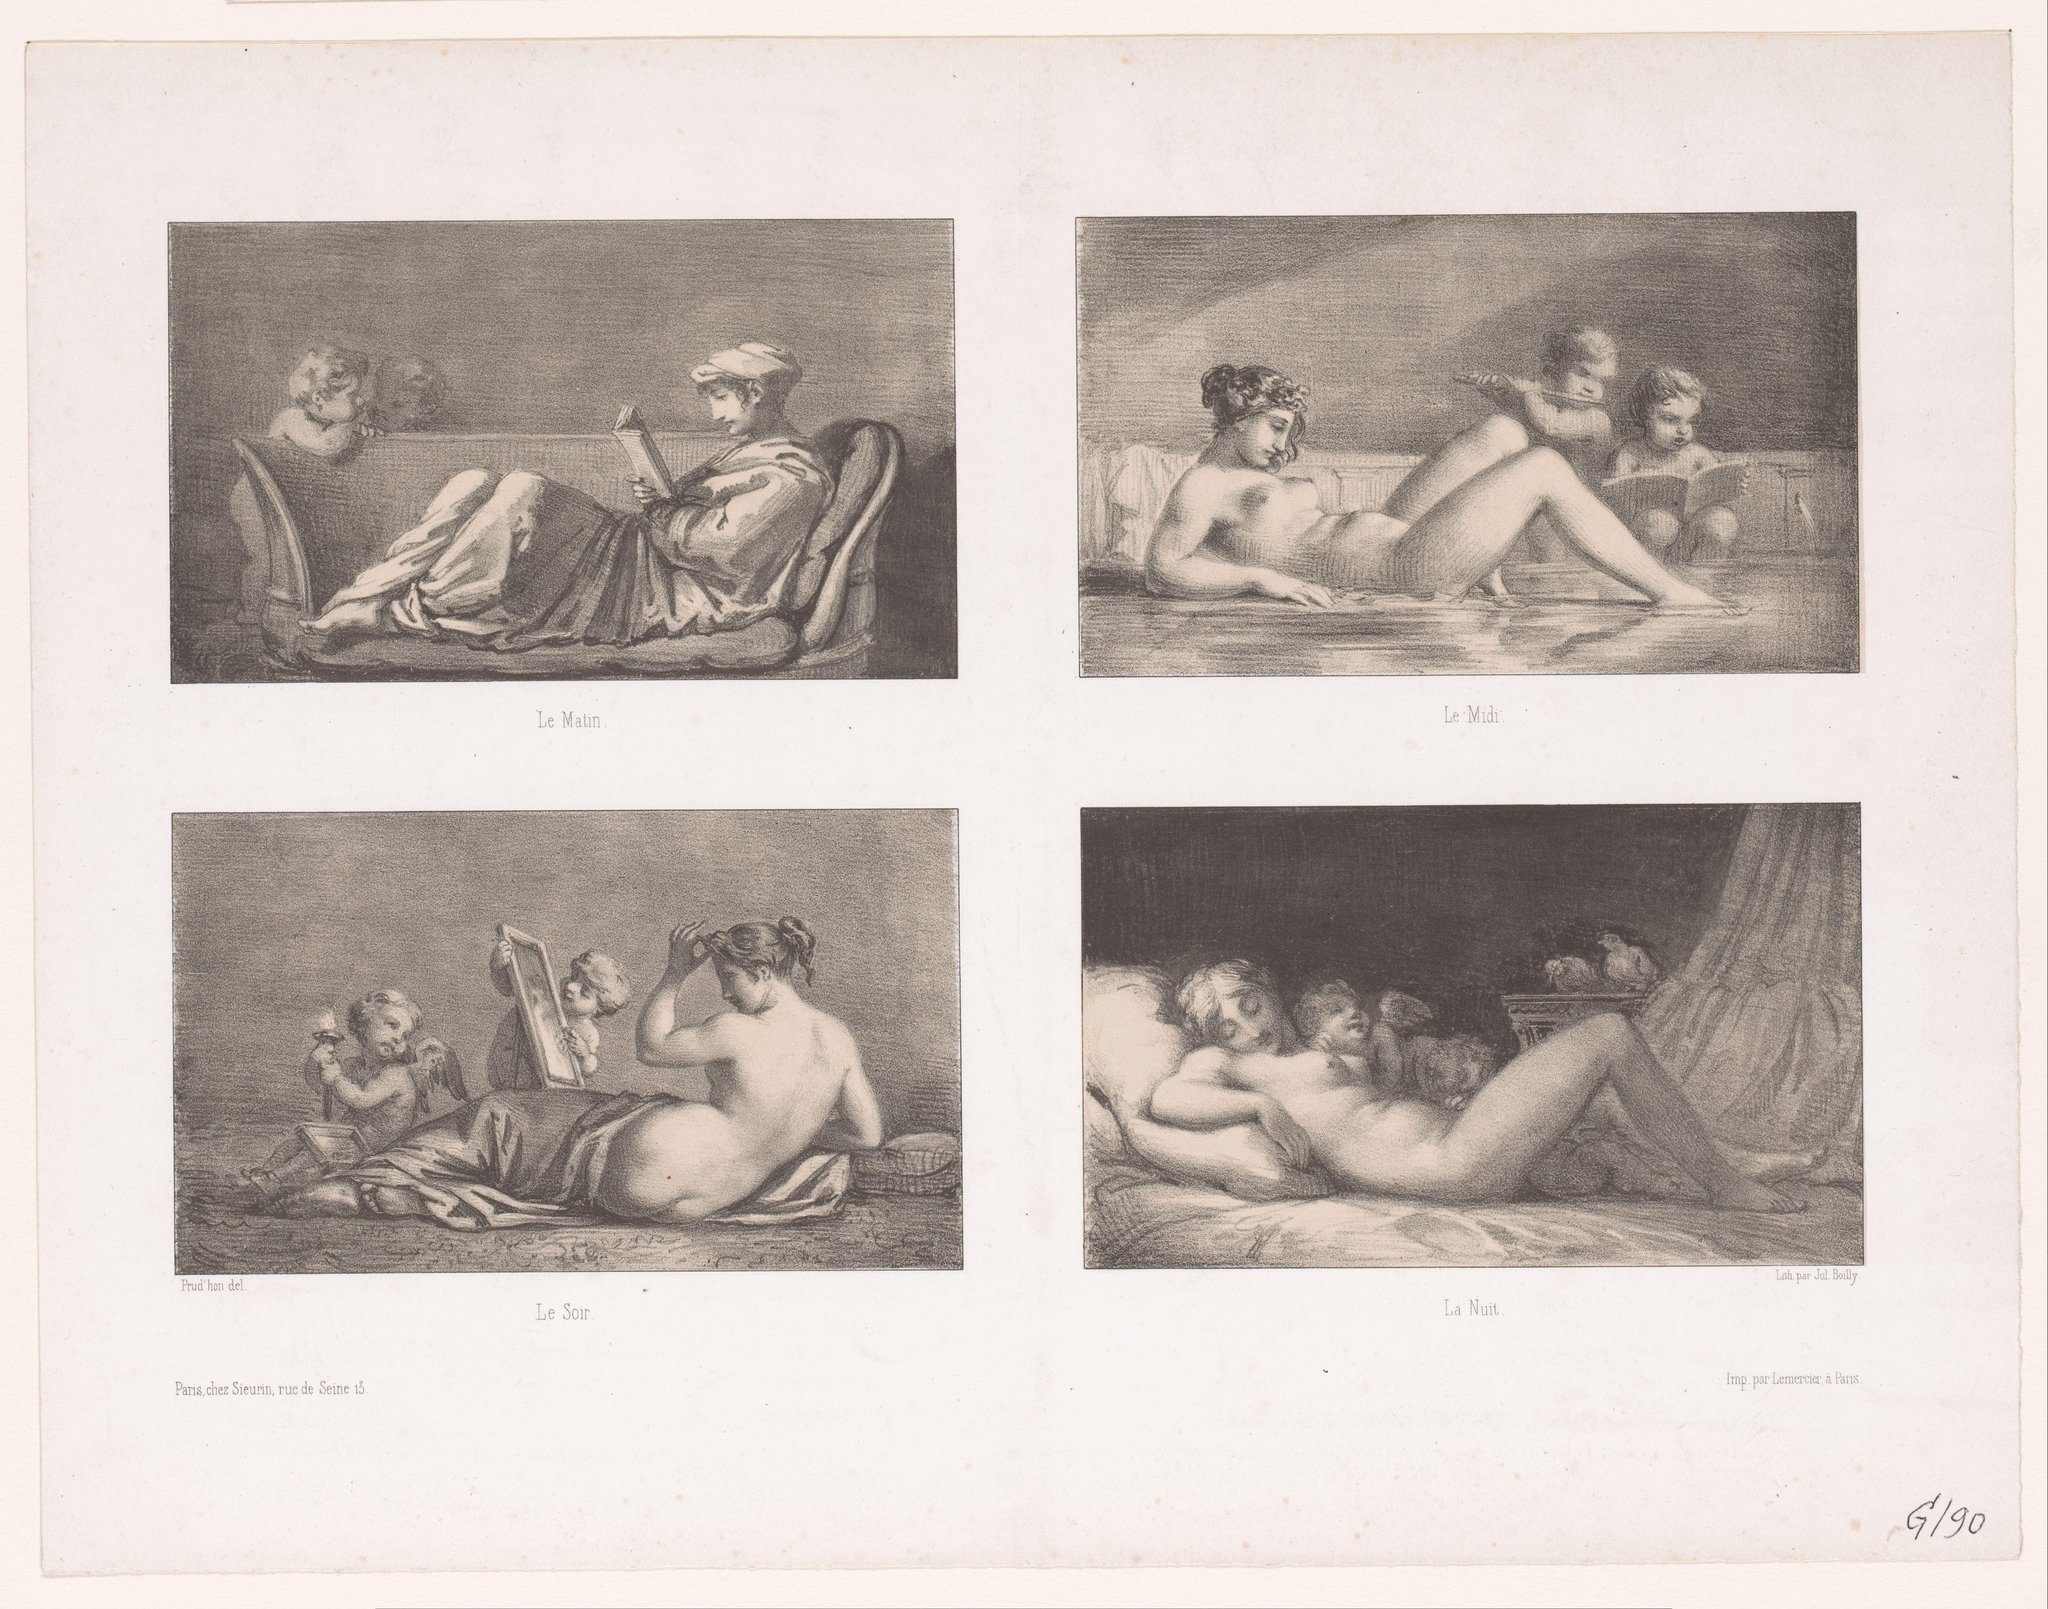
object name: print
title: Tijdstippen van de dag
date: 1849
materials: paper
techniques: lithograph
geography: paris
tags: evening, morning, afternoon, night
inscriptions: collector's mark: Lugt 2228, collector's mark: Lugt 2760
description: Onversneden blad met vier prenten. Vier vrouwen die symbool staan voor respectievelijk de ochtend, middag, avond en nacht.